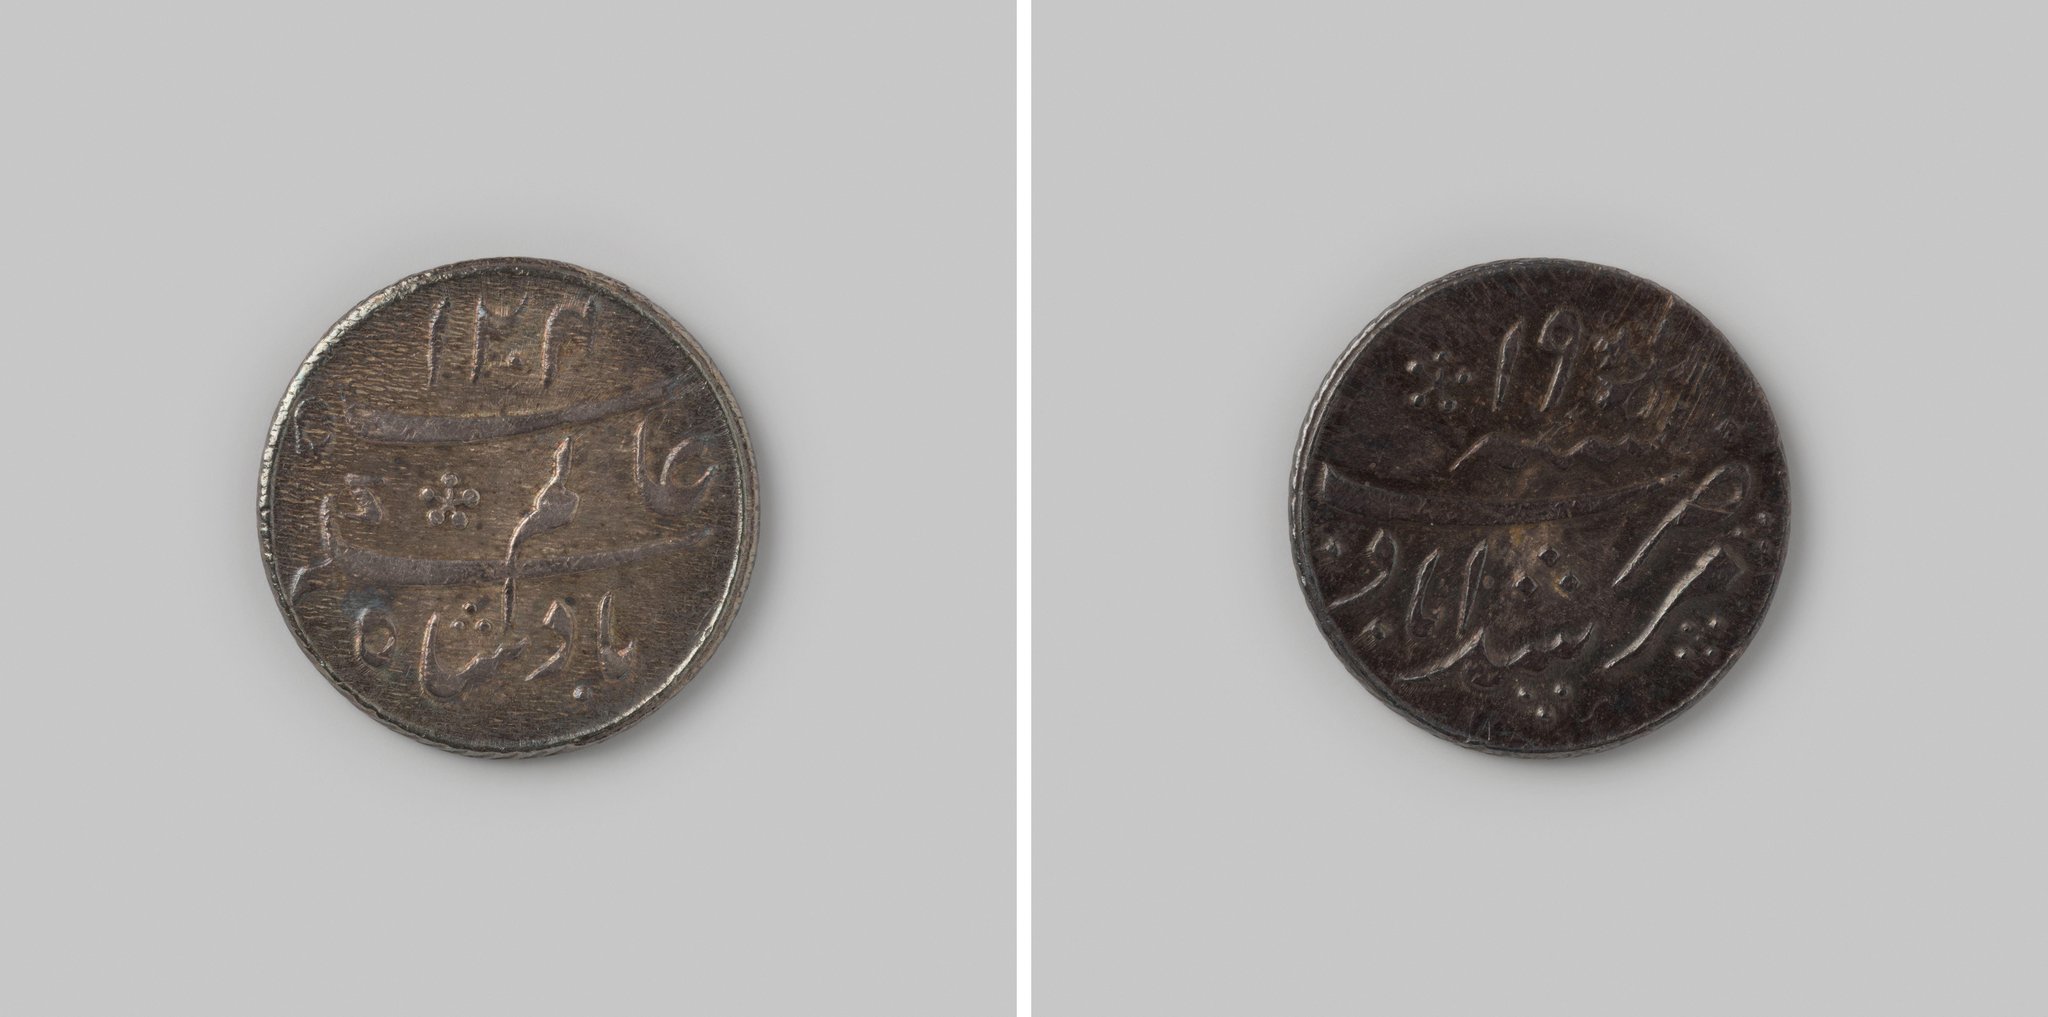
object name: coin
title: ½ roepie uit Bengalen in India van de Engelse Oostindische Compagnie (EIC) op naam van Sjah Alam I, 1202 [=1788] en regeringsjaar 19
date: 1793-1818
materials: silver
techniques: striking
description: Zilveren munt. Voorzijde: in Arabische lettertekens in twee regels opschrift. Bovenaan jaartal:1202 [=1788]. Keerzijde: in Arabische lettertekens in twee regels opschrift. Bovenaan aanduiding van het "eeuwige" regeringsjaar: 19. Kabelrand.